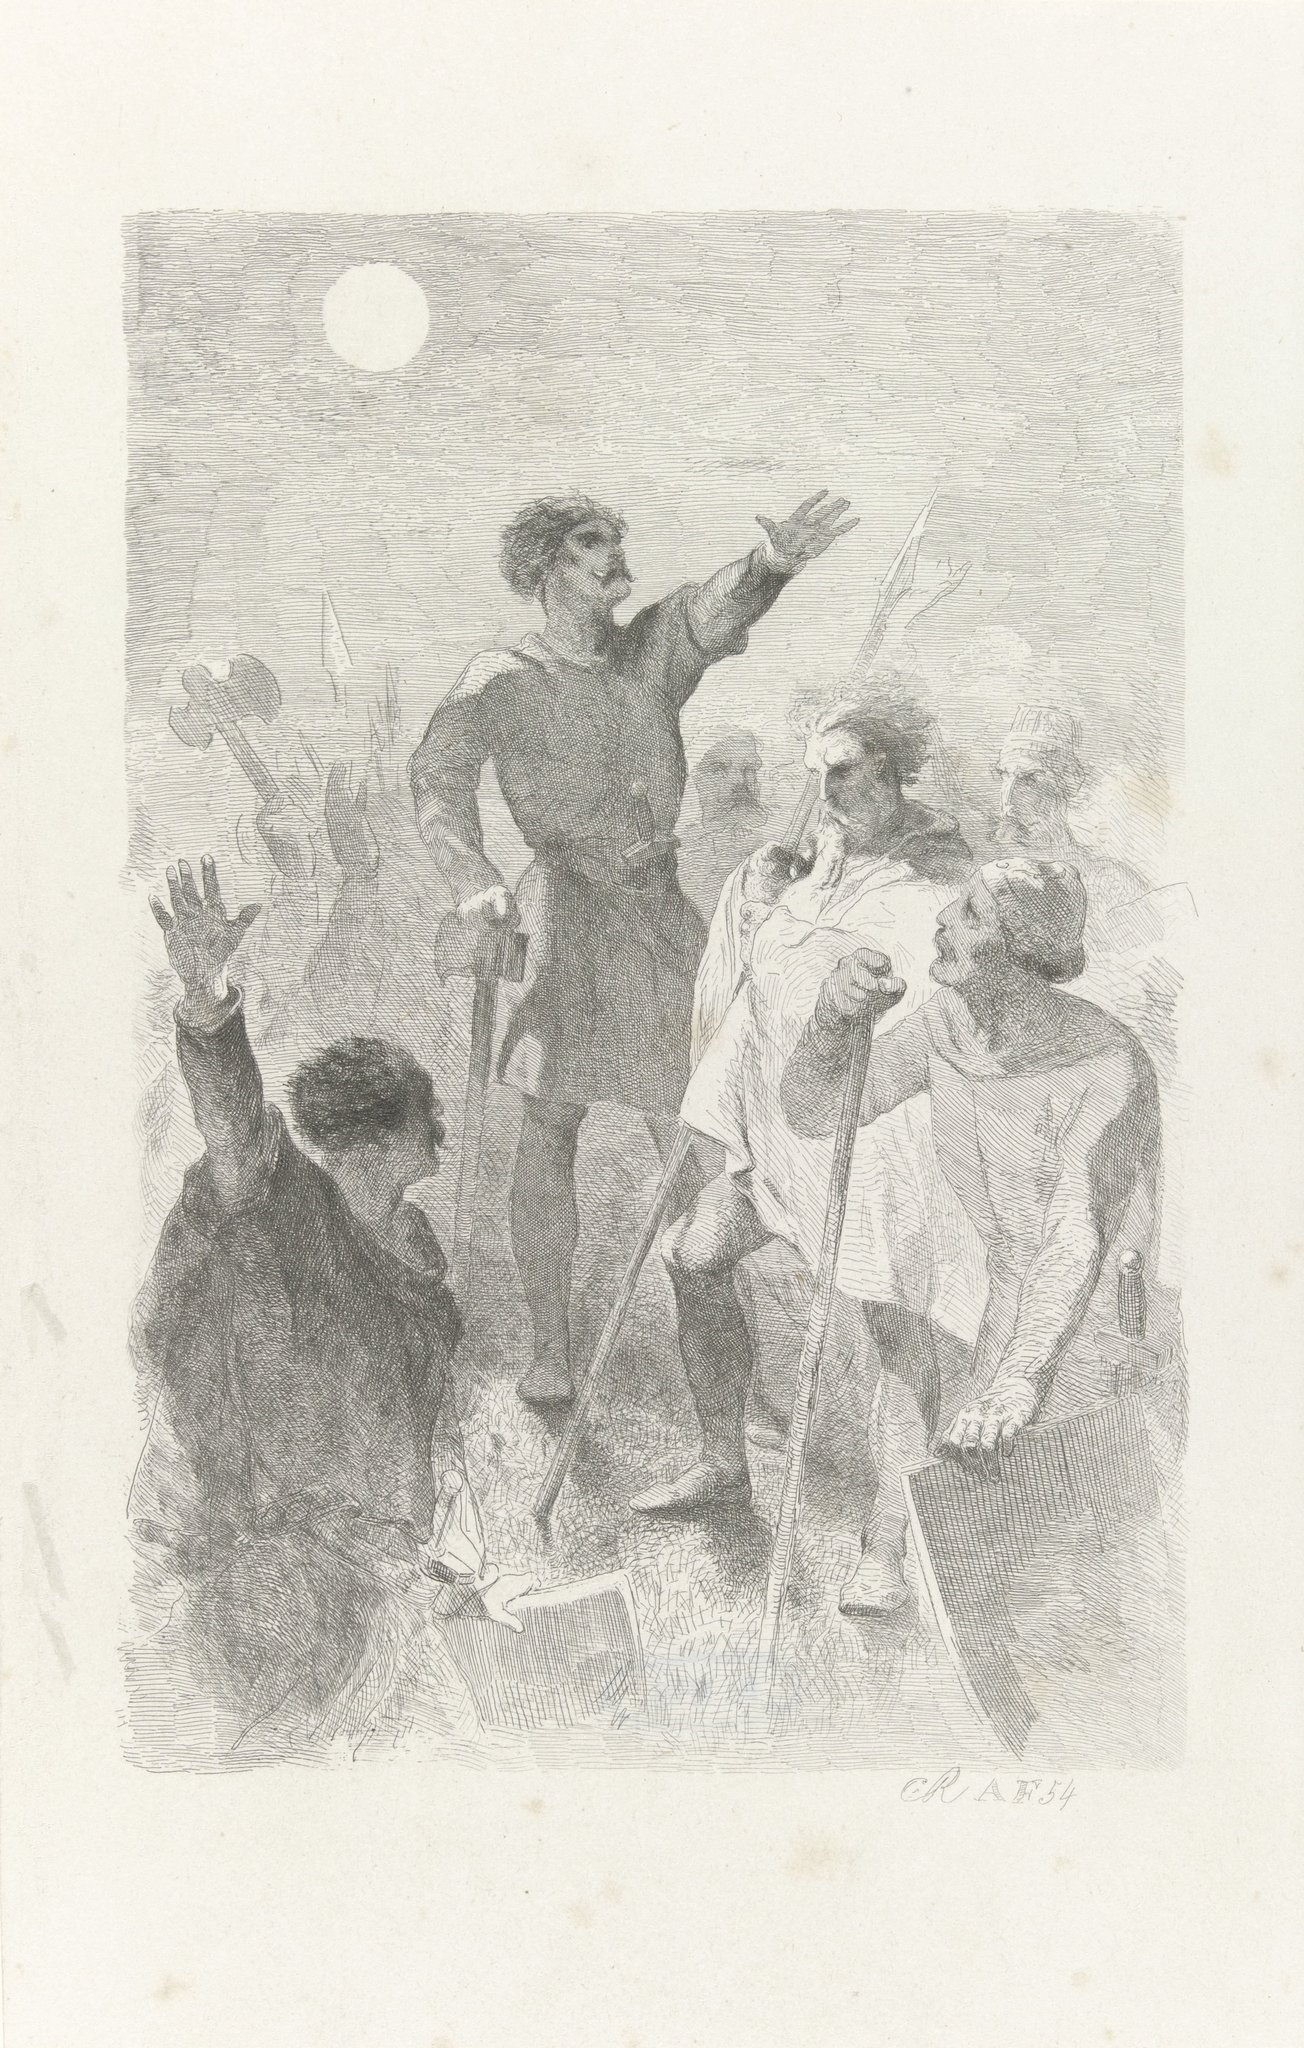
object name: print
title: Wilfried omringd door zijn krijgers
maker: charles rochussen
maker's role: draughtsman, painter, print maker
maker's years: 1814-1894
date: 1854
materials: paper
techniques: steel etching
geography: amsterdam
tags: the soldier; the soldier's life (+ weapons), military instruction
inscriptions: collector's mark: Lugt 2228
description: Wilfried is door zijn krijgers omringd. Illustratie van een scène uit een boek met gedichten genaamd 'Helene'.